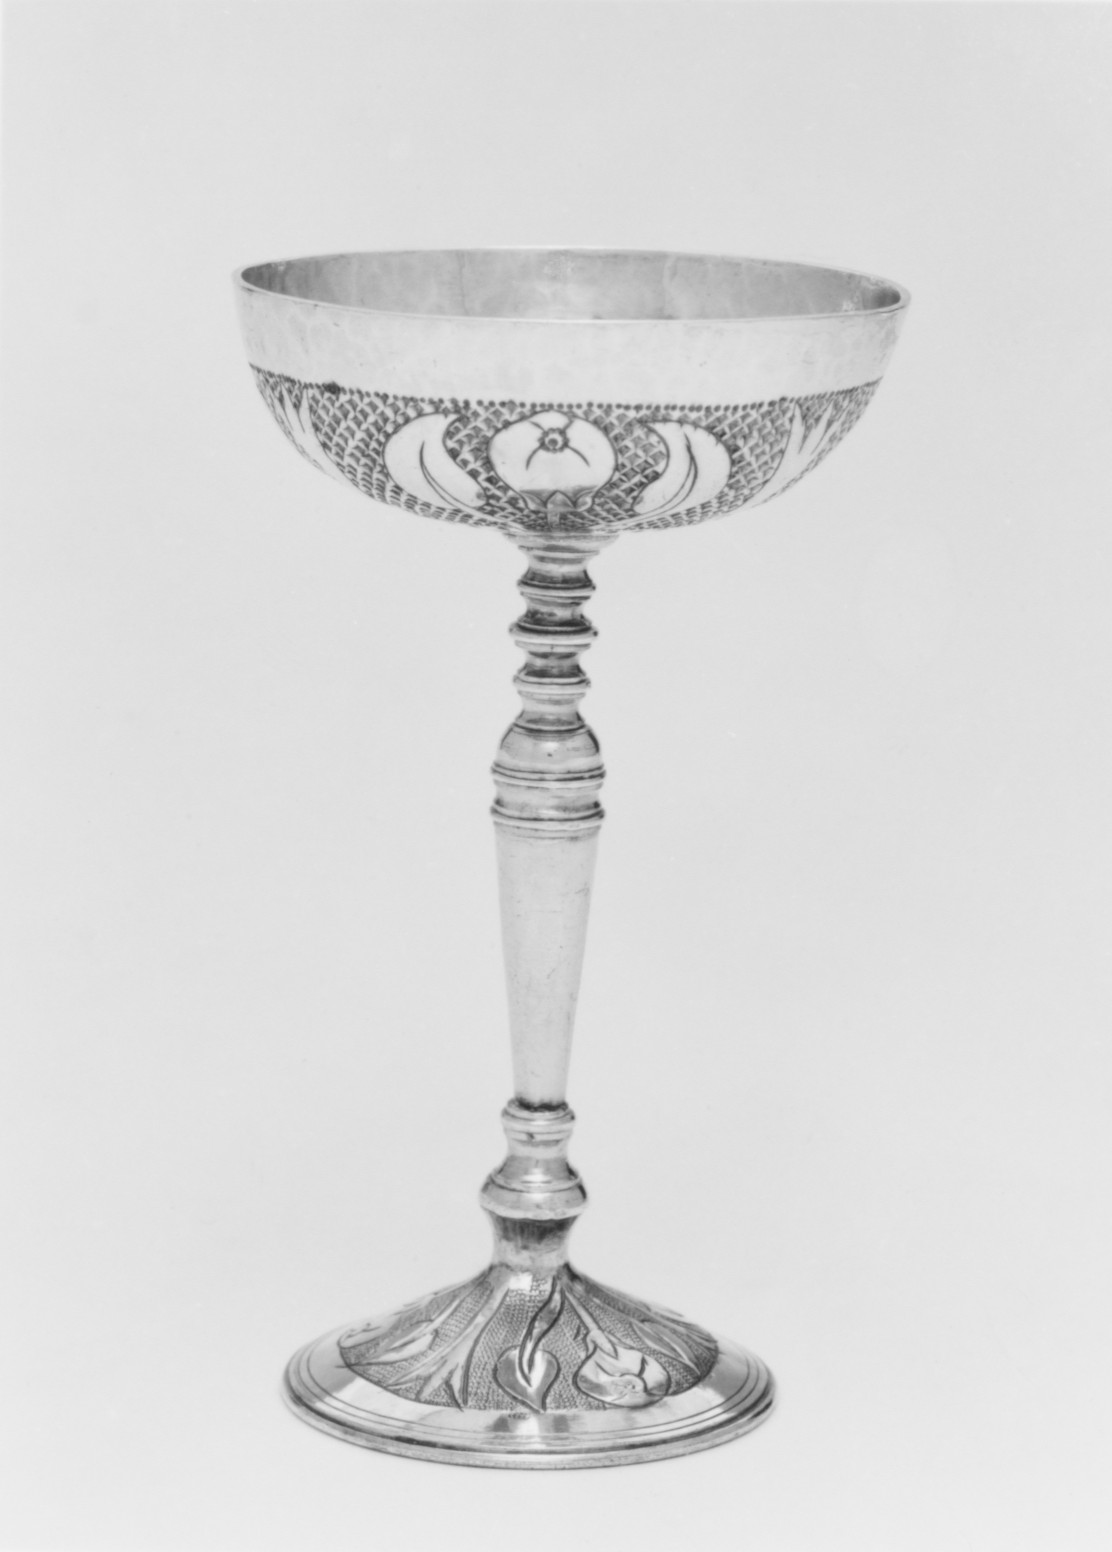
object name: wine cup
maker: f. m., london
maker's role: maker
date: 1619-1620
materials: silver gilt